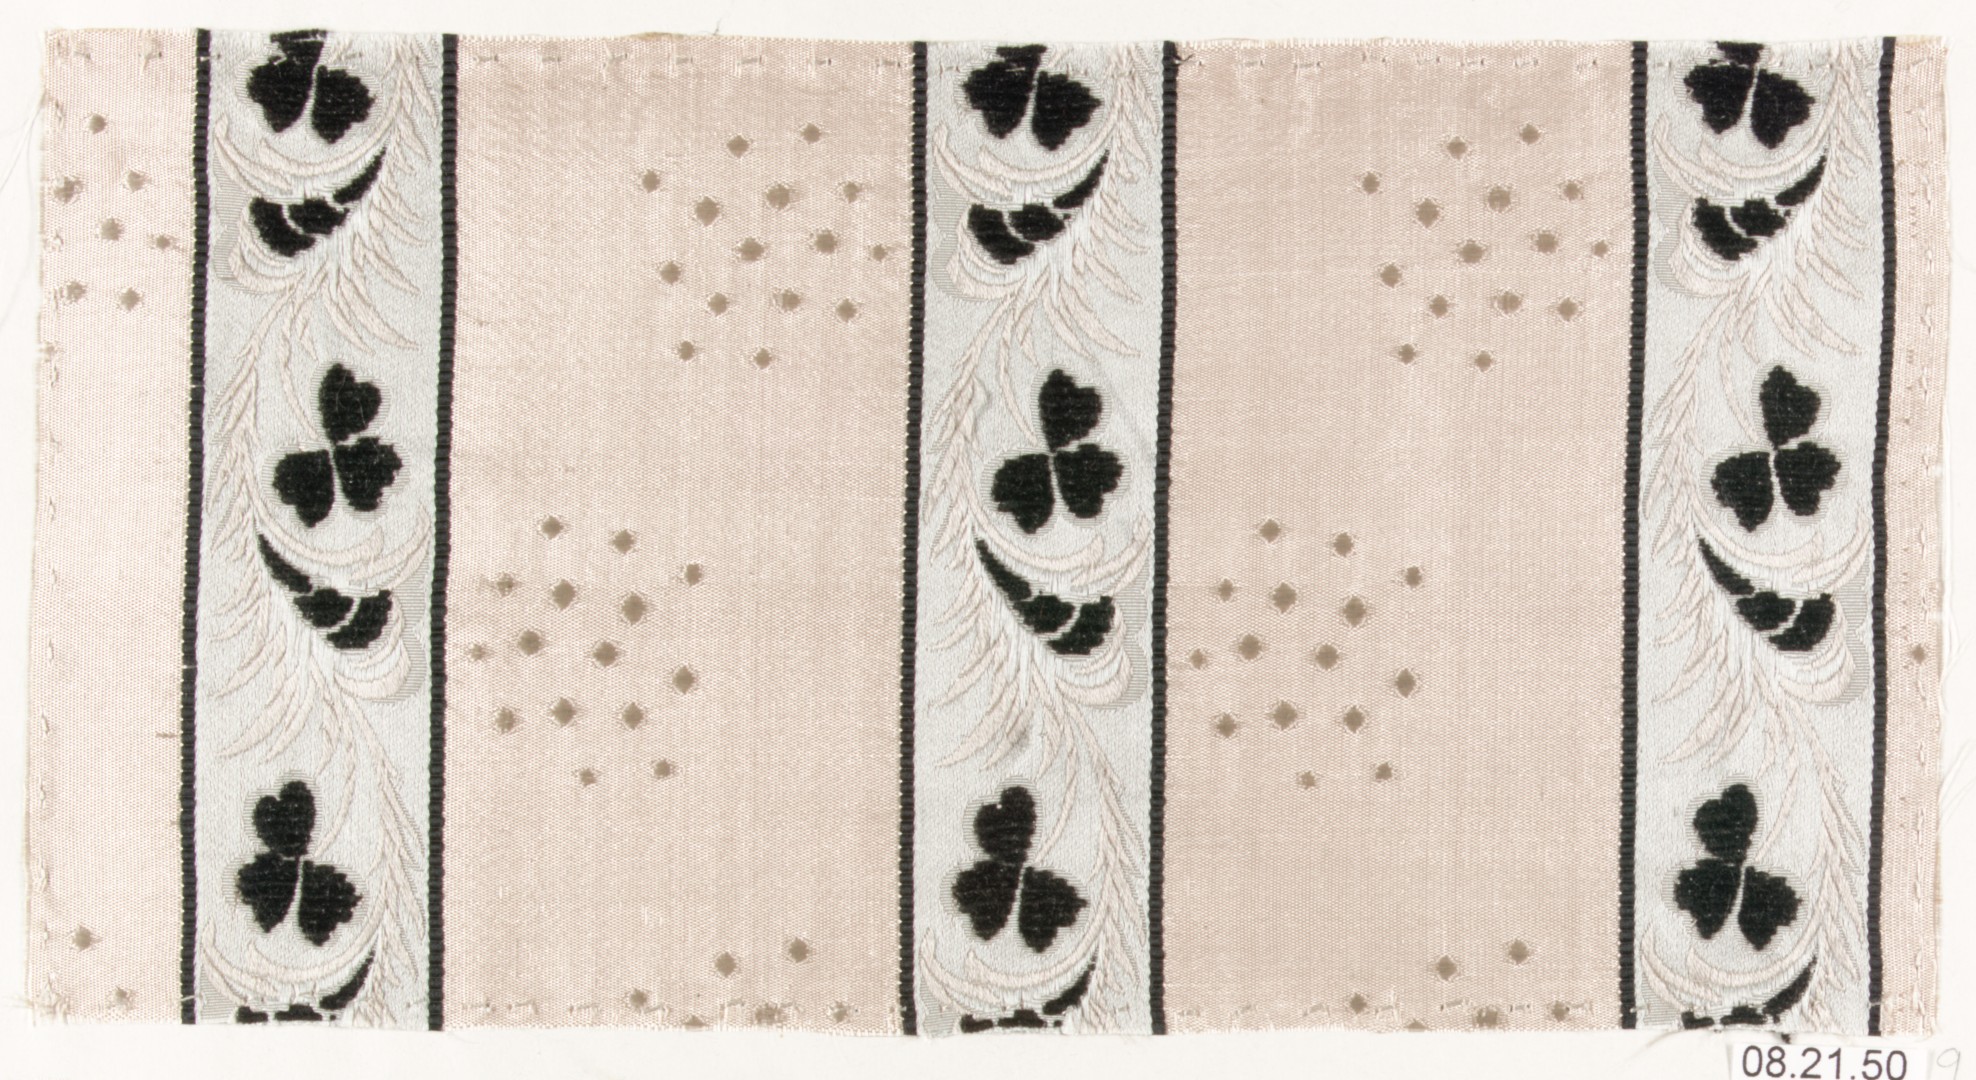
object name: textile sample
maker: Anonymous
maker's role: designer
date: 1900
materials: silk